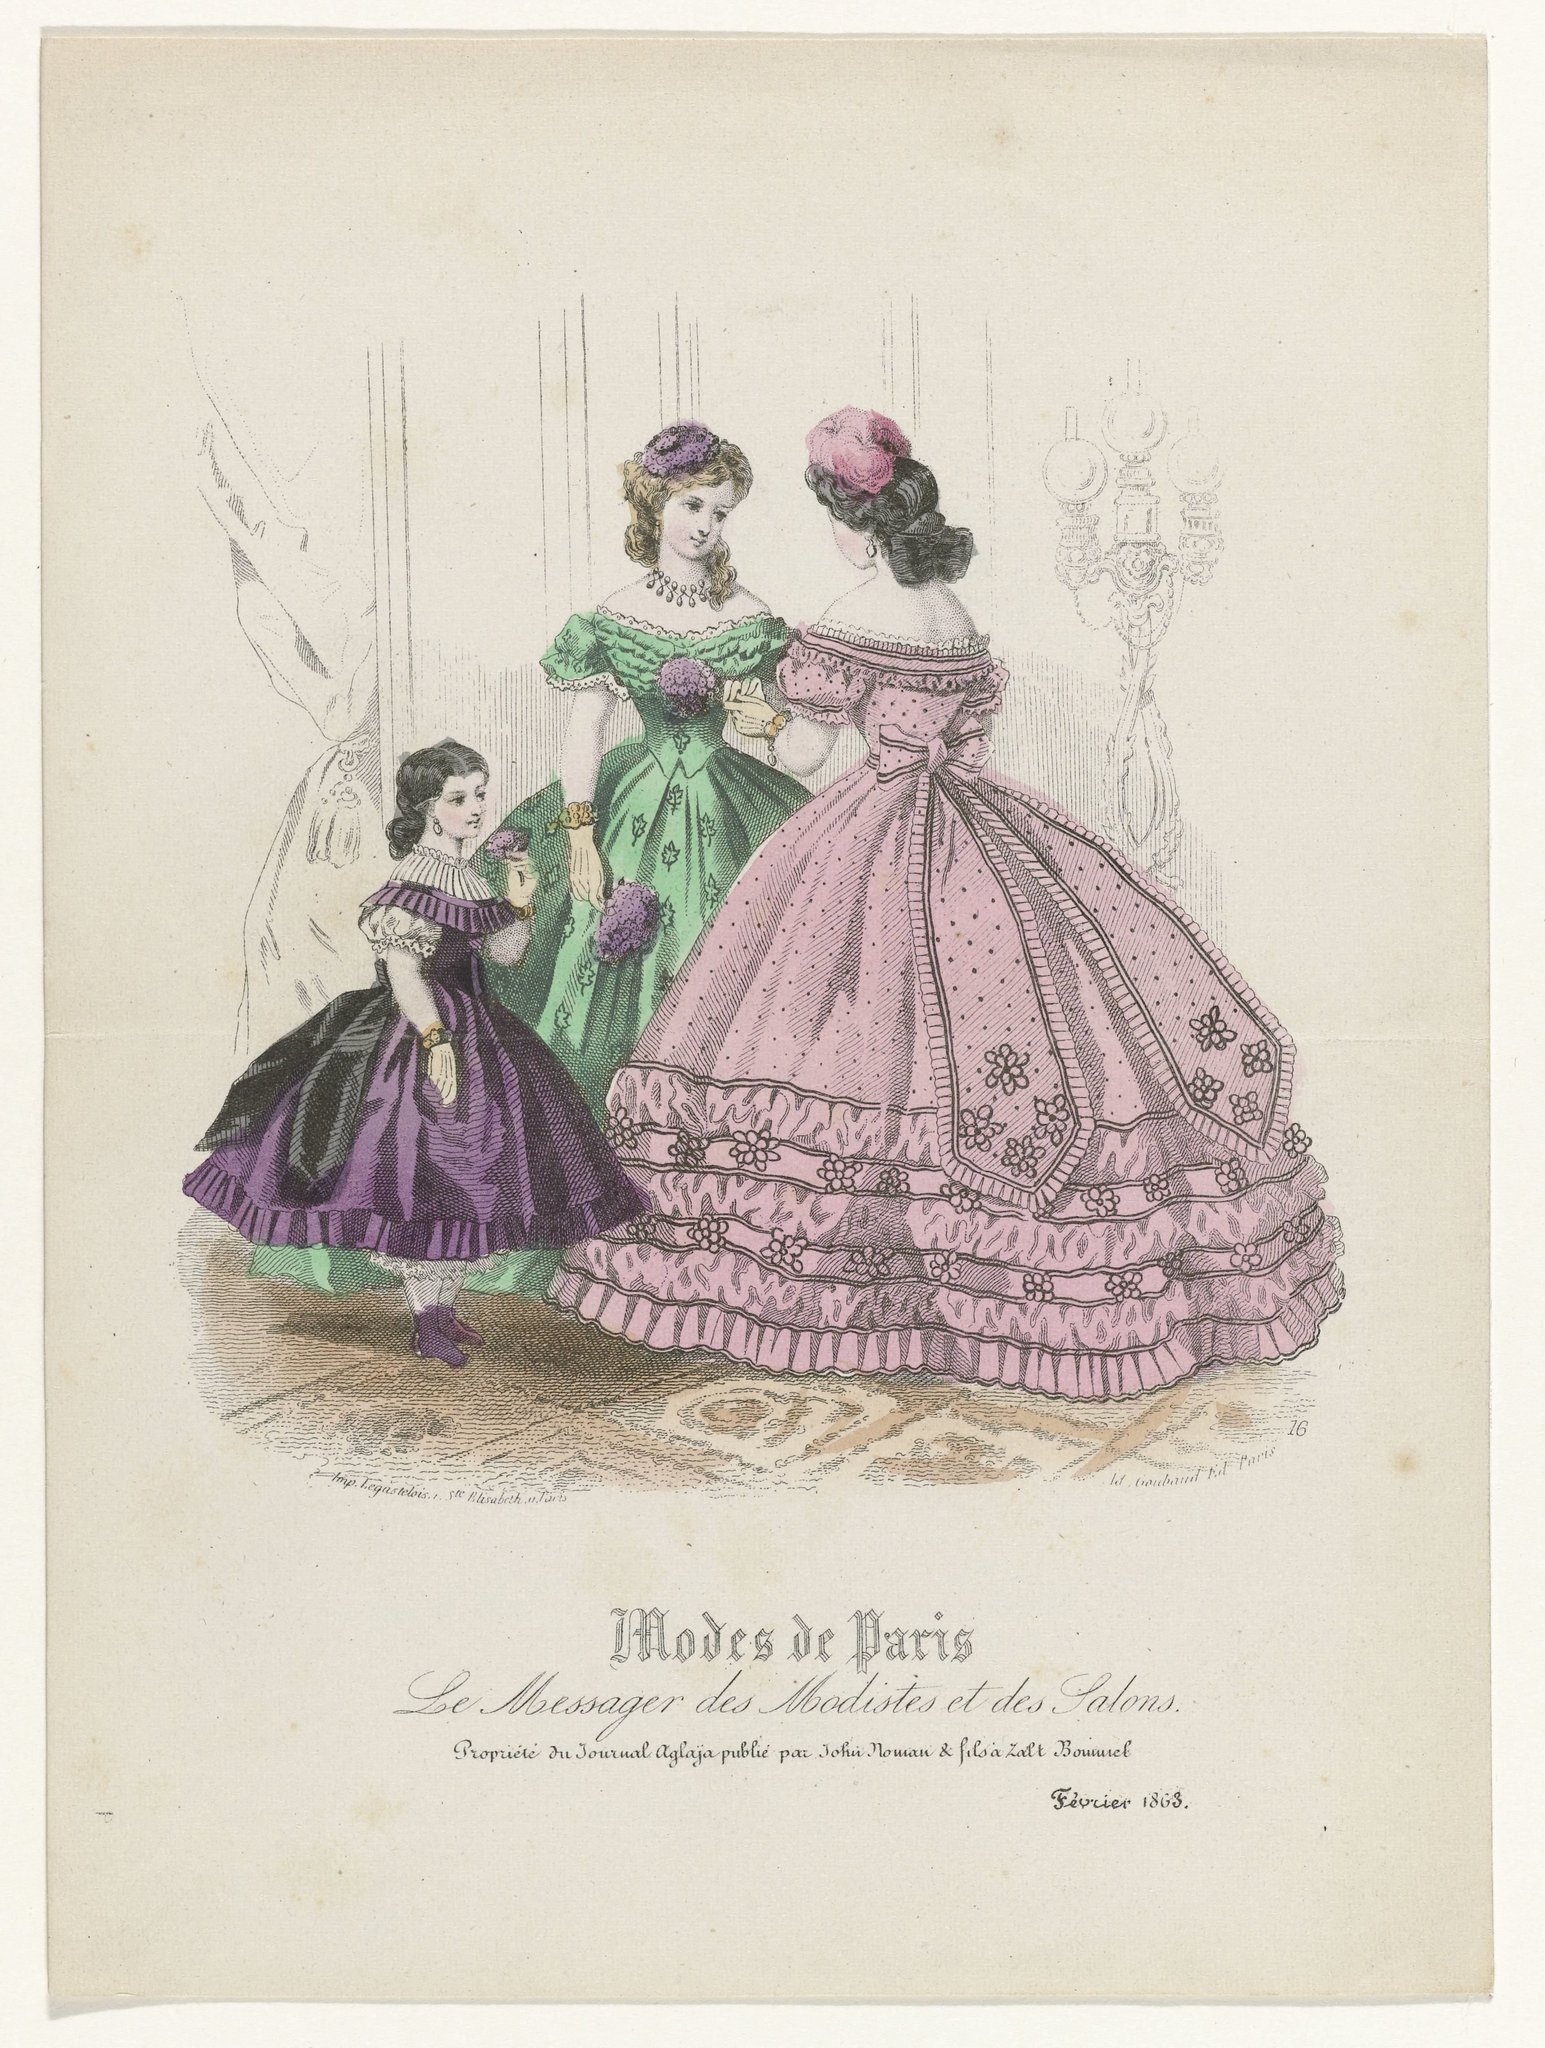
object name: fashion print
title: Le Messager des Modistes et des Salons, Modes de Paris, Journal Aglaja, février 1863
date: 1863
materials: paper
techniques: engraving, hand coloring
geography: zaltbommel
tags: cut flowers; nosegay, bunch of flowers, dress, gown: evening dress (+ women's clothes), dress, gown: evening dress (+ girls' clothes), fashion plates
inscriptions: caption: ‘Propriété du Journal Aglaja publié par John Noman & fils à Zalt Bommel’, title: ‘Modes de Paris / Le Messager des Modistes et des Salons.’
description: Twee vrouwen en een meisje in avondjaponnen met boothals en korte pofmouwen. De prent werd opgenomen in Aglaja (1848-1864), maandboekje voor dames handwerken, uitgegeven door A. C. Kruseman te Haarlem.